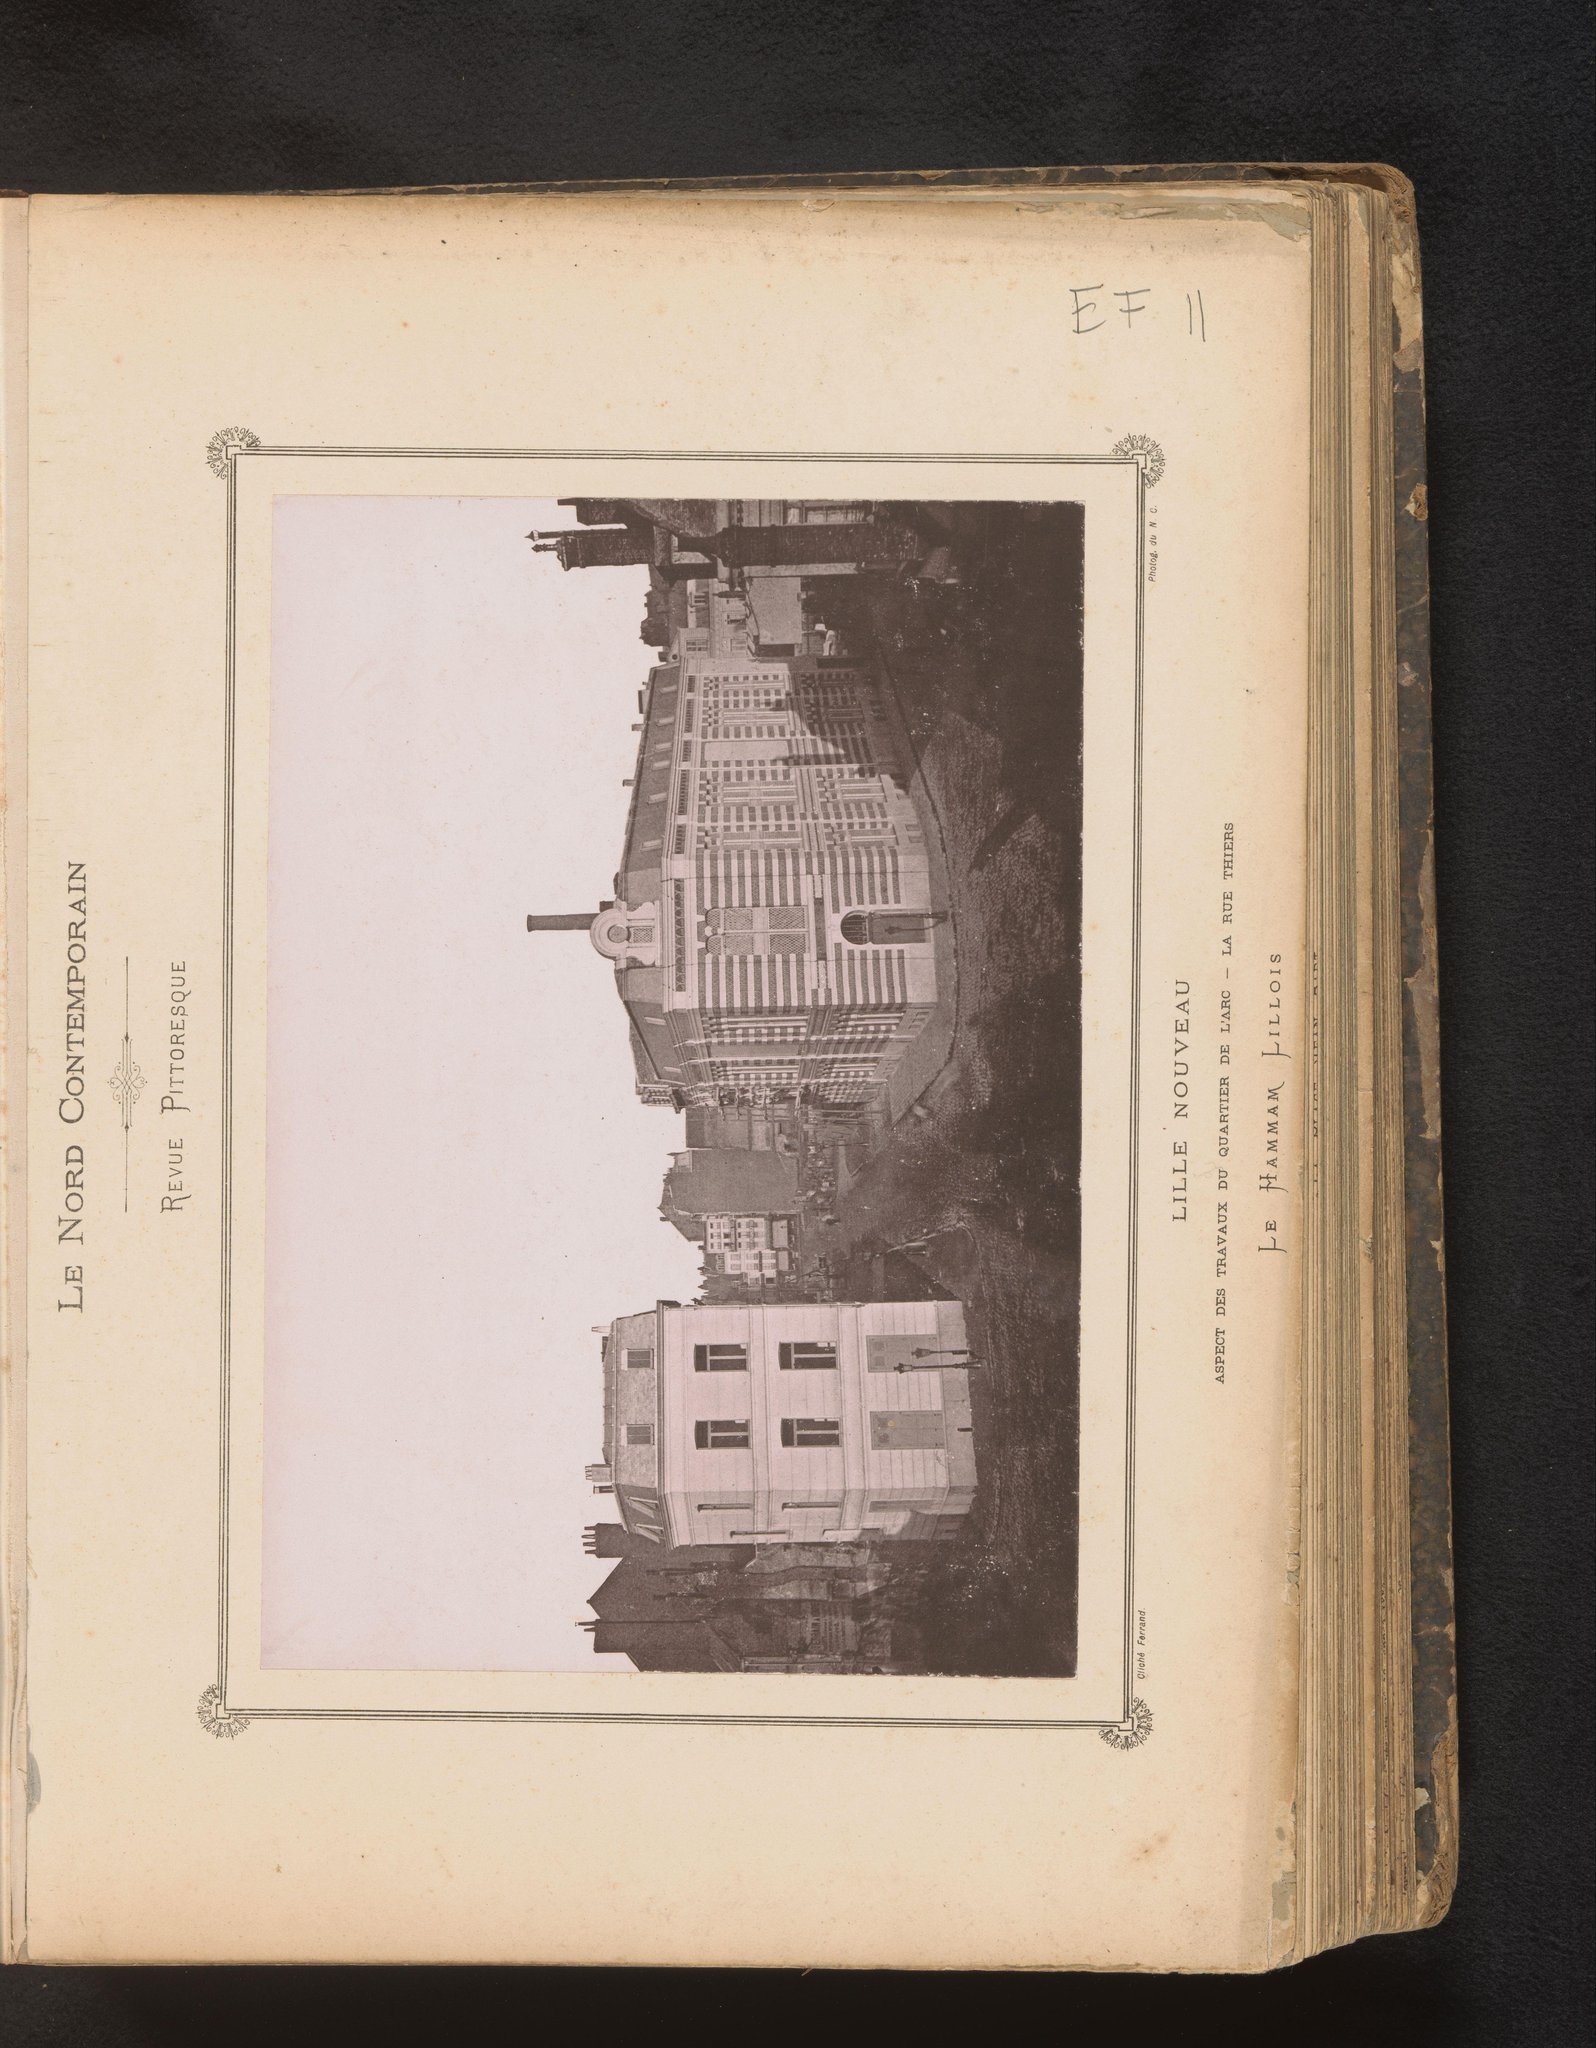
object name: page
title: Lille Nouveau, Aspect des Travaux du Cartier de l'Arc - La Rue Thiers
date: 1877-1882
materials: paper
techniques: photograph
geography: lille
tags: public baths, street, lille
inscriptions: inscription: ‘Le Nord Contemporain/ Revue Pittoresque’, annotation: ‘EF II’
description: Prent op vijfde ongenummerde pagina na pagina 336.